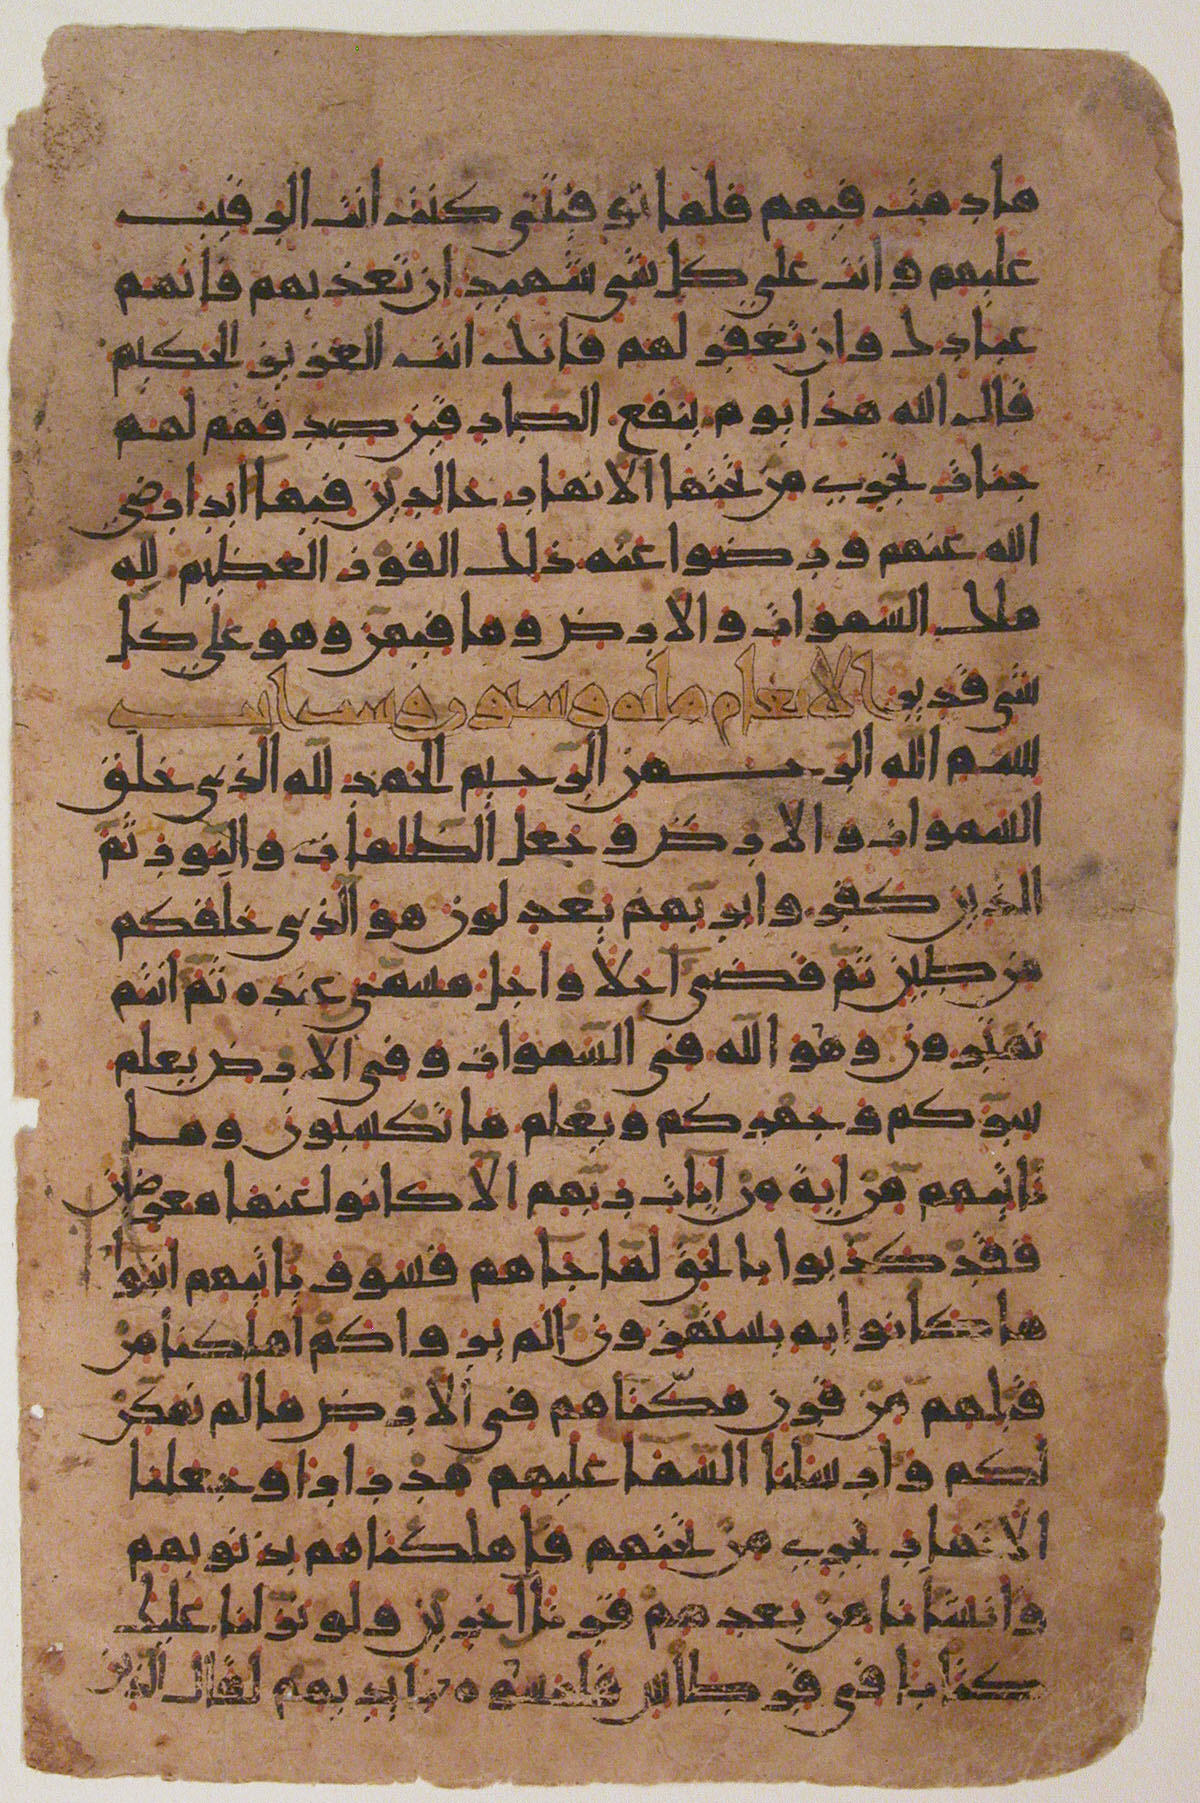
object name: folio from a non illustrated manuscript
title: Folio from a Qur'an Manuscript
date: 901-1000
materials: ink, paper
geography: iran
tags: qur'an